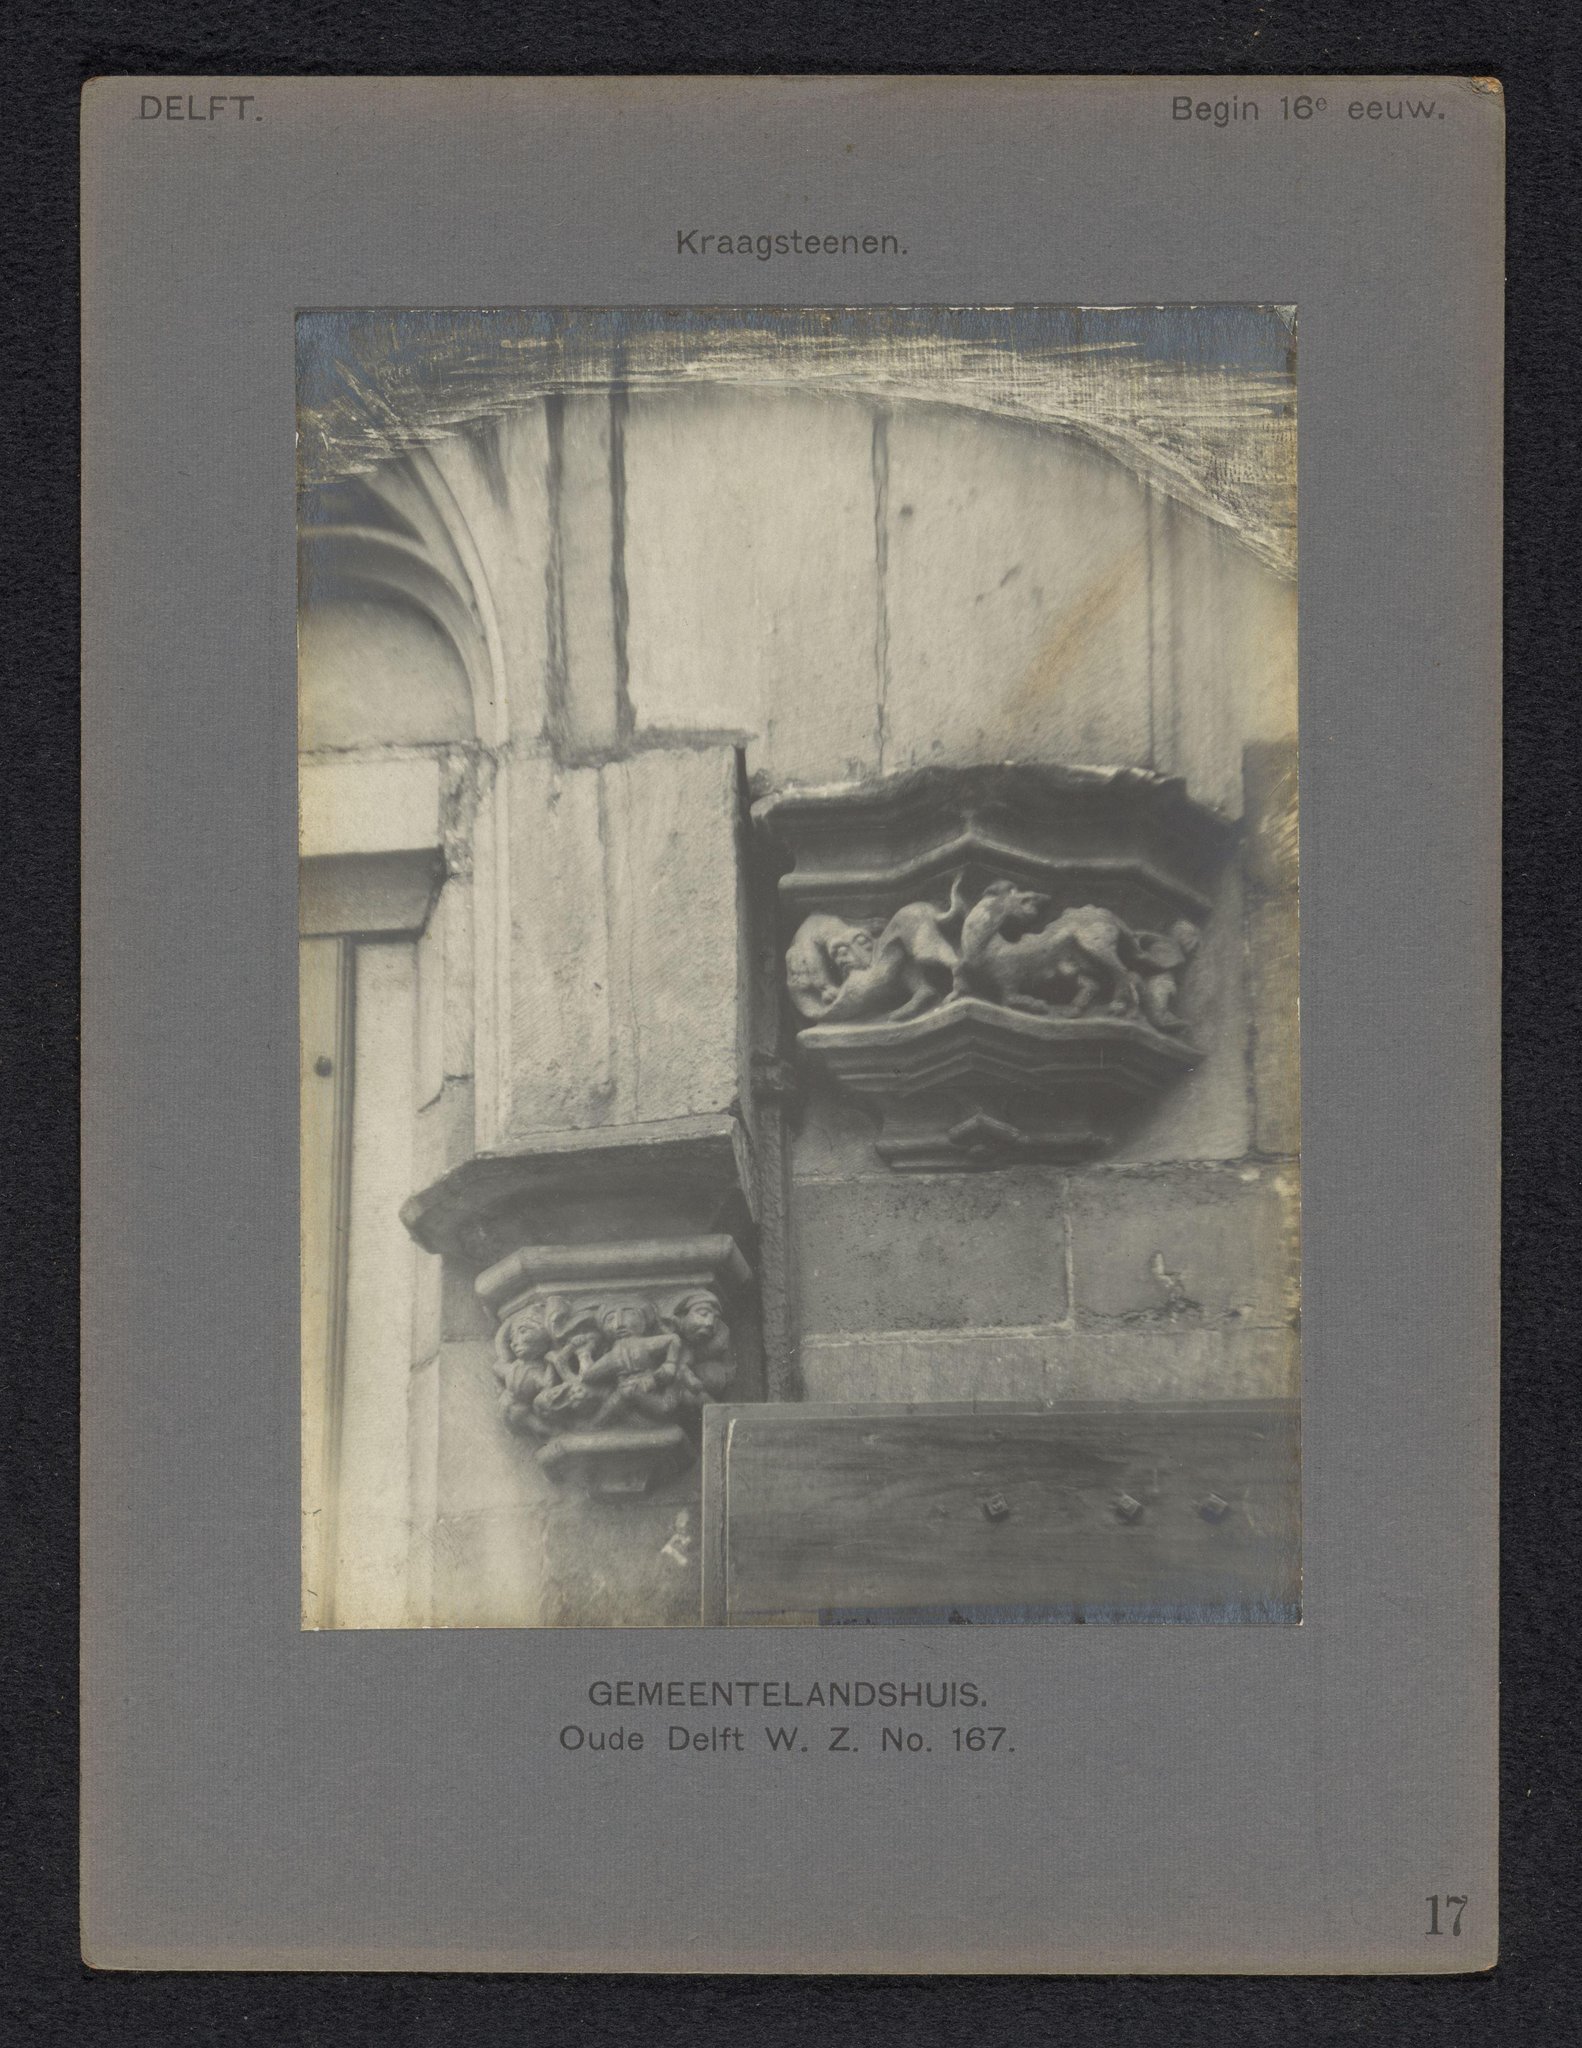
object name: photograph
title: Kraagstenen van het Gemeenlandshuis aan de Oude Delft in Delft gedecoreerd met fantasiewezens en mensen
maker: Anonymous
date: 1900-1904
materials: cardboard, photographic support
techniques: gelatin silver print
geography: delft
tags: ornament ~ hybrid animals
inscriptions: number: ‘17’, inscription: ‘Delft. Begin 16e eeuw.’, inscription: ‘Het recht van reproductie dezer photo's wordt door den Uitgever voorbehouden.’, number: ‘23’